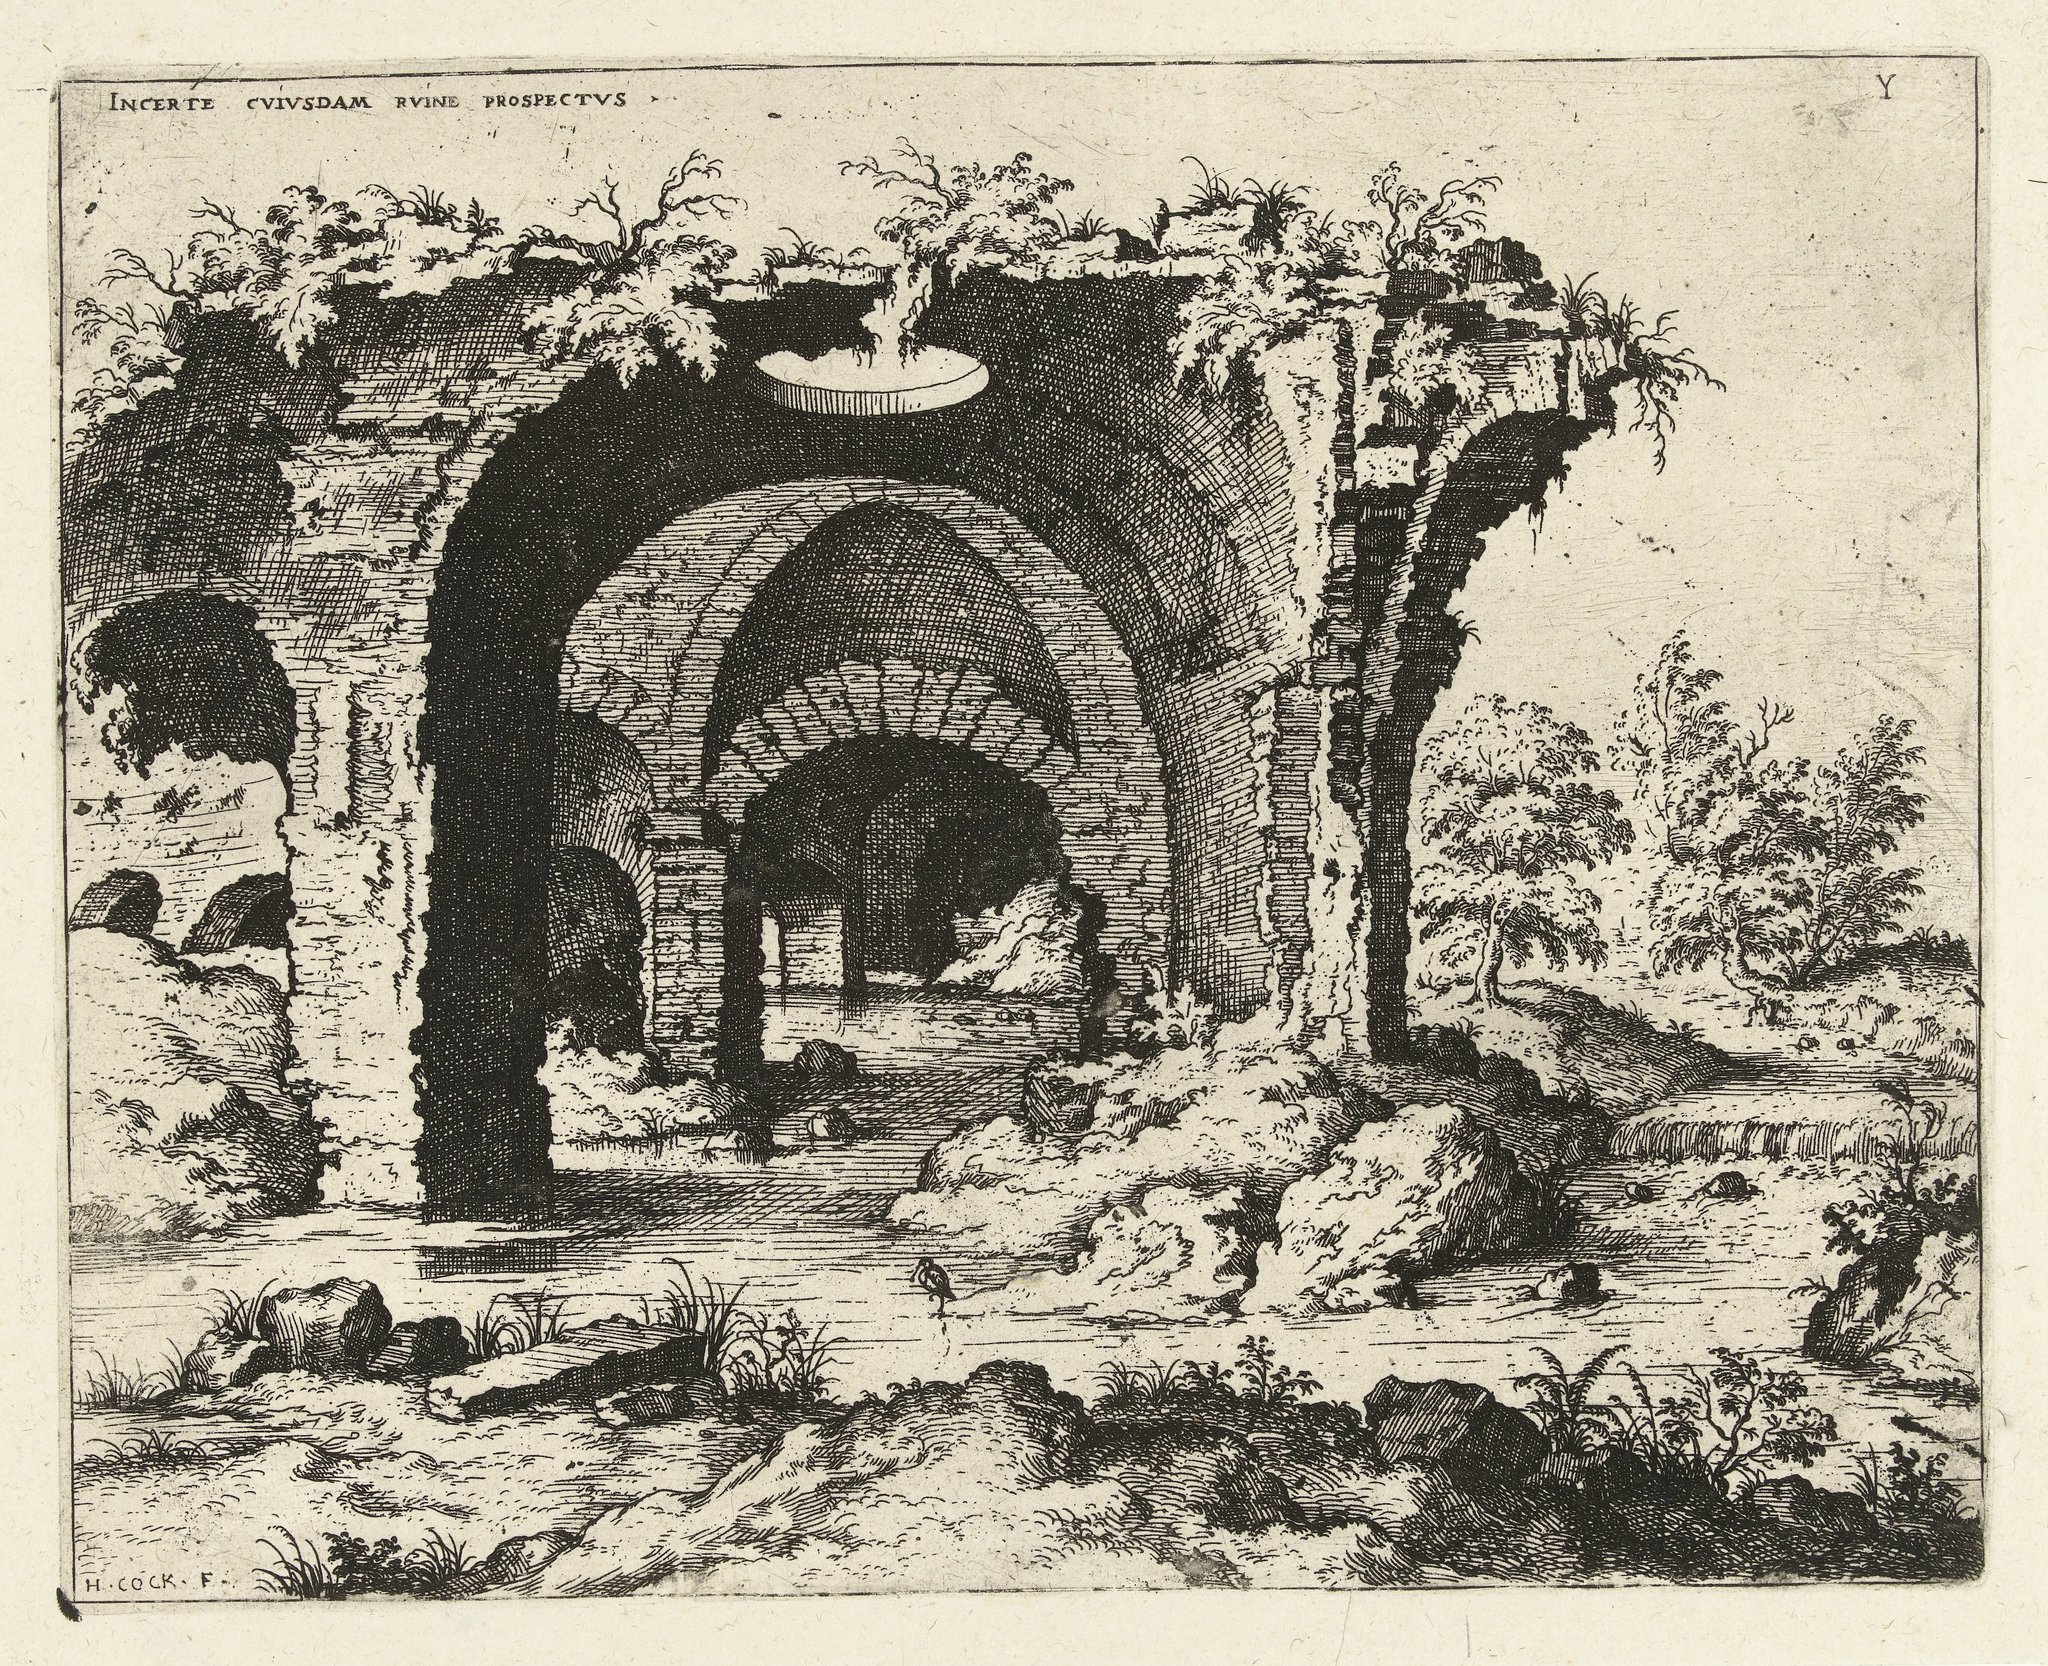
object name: print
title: Incerte cvivsdam rvine prospectvs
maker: hieronymus cock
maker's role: print maker, publisher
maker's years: 1518-1570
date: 1551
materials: paper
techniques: etching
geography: antwerp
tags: ruin of a building ~ architecture, rome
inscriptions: collector's mark: Lugt 2228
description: Gezicht op een onbekende ruïne, waarschijnlijk uit Rome.Tussen de overblijfselen van de gebouwen staat water, rechts loopt een beek. Prent uit een serie van 25 prenten met Romeinse ruïnes.